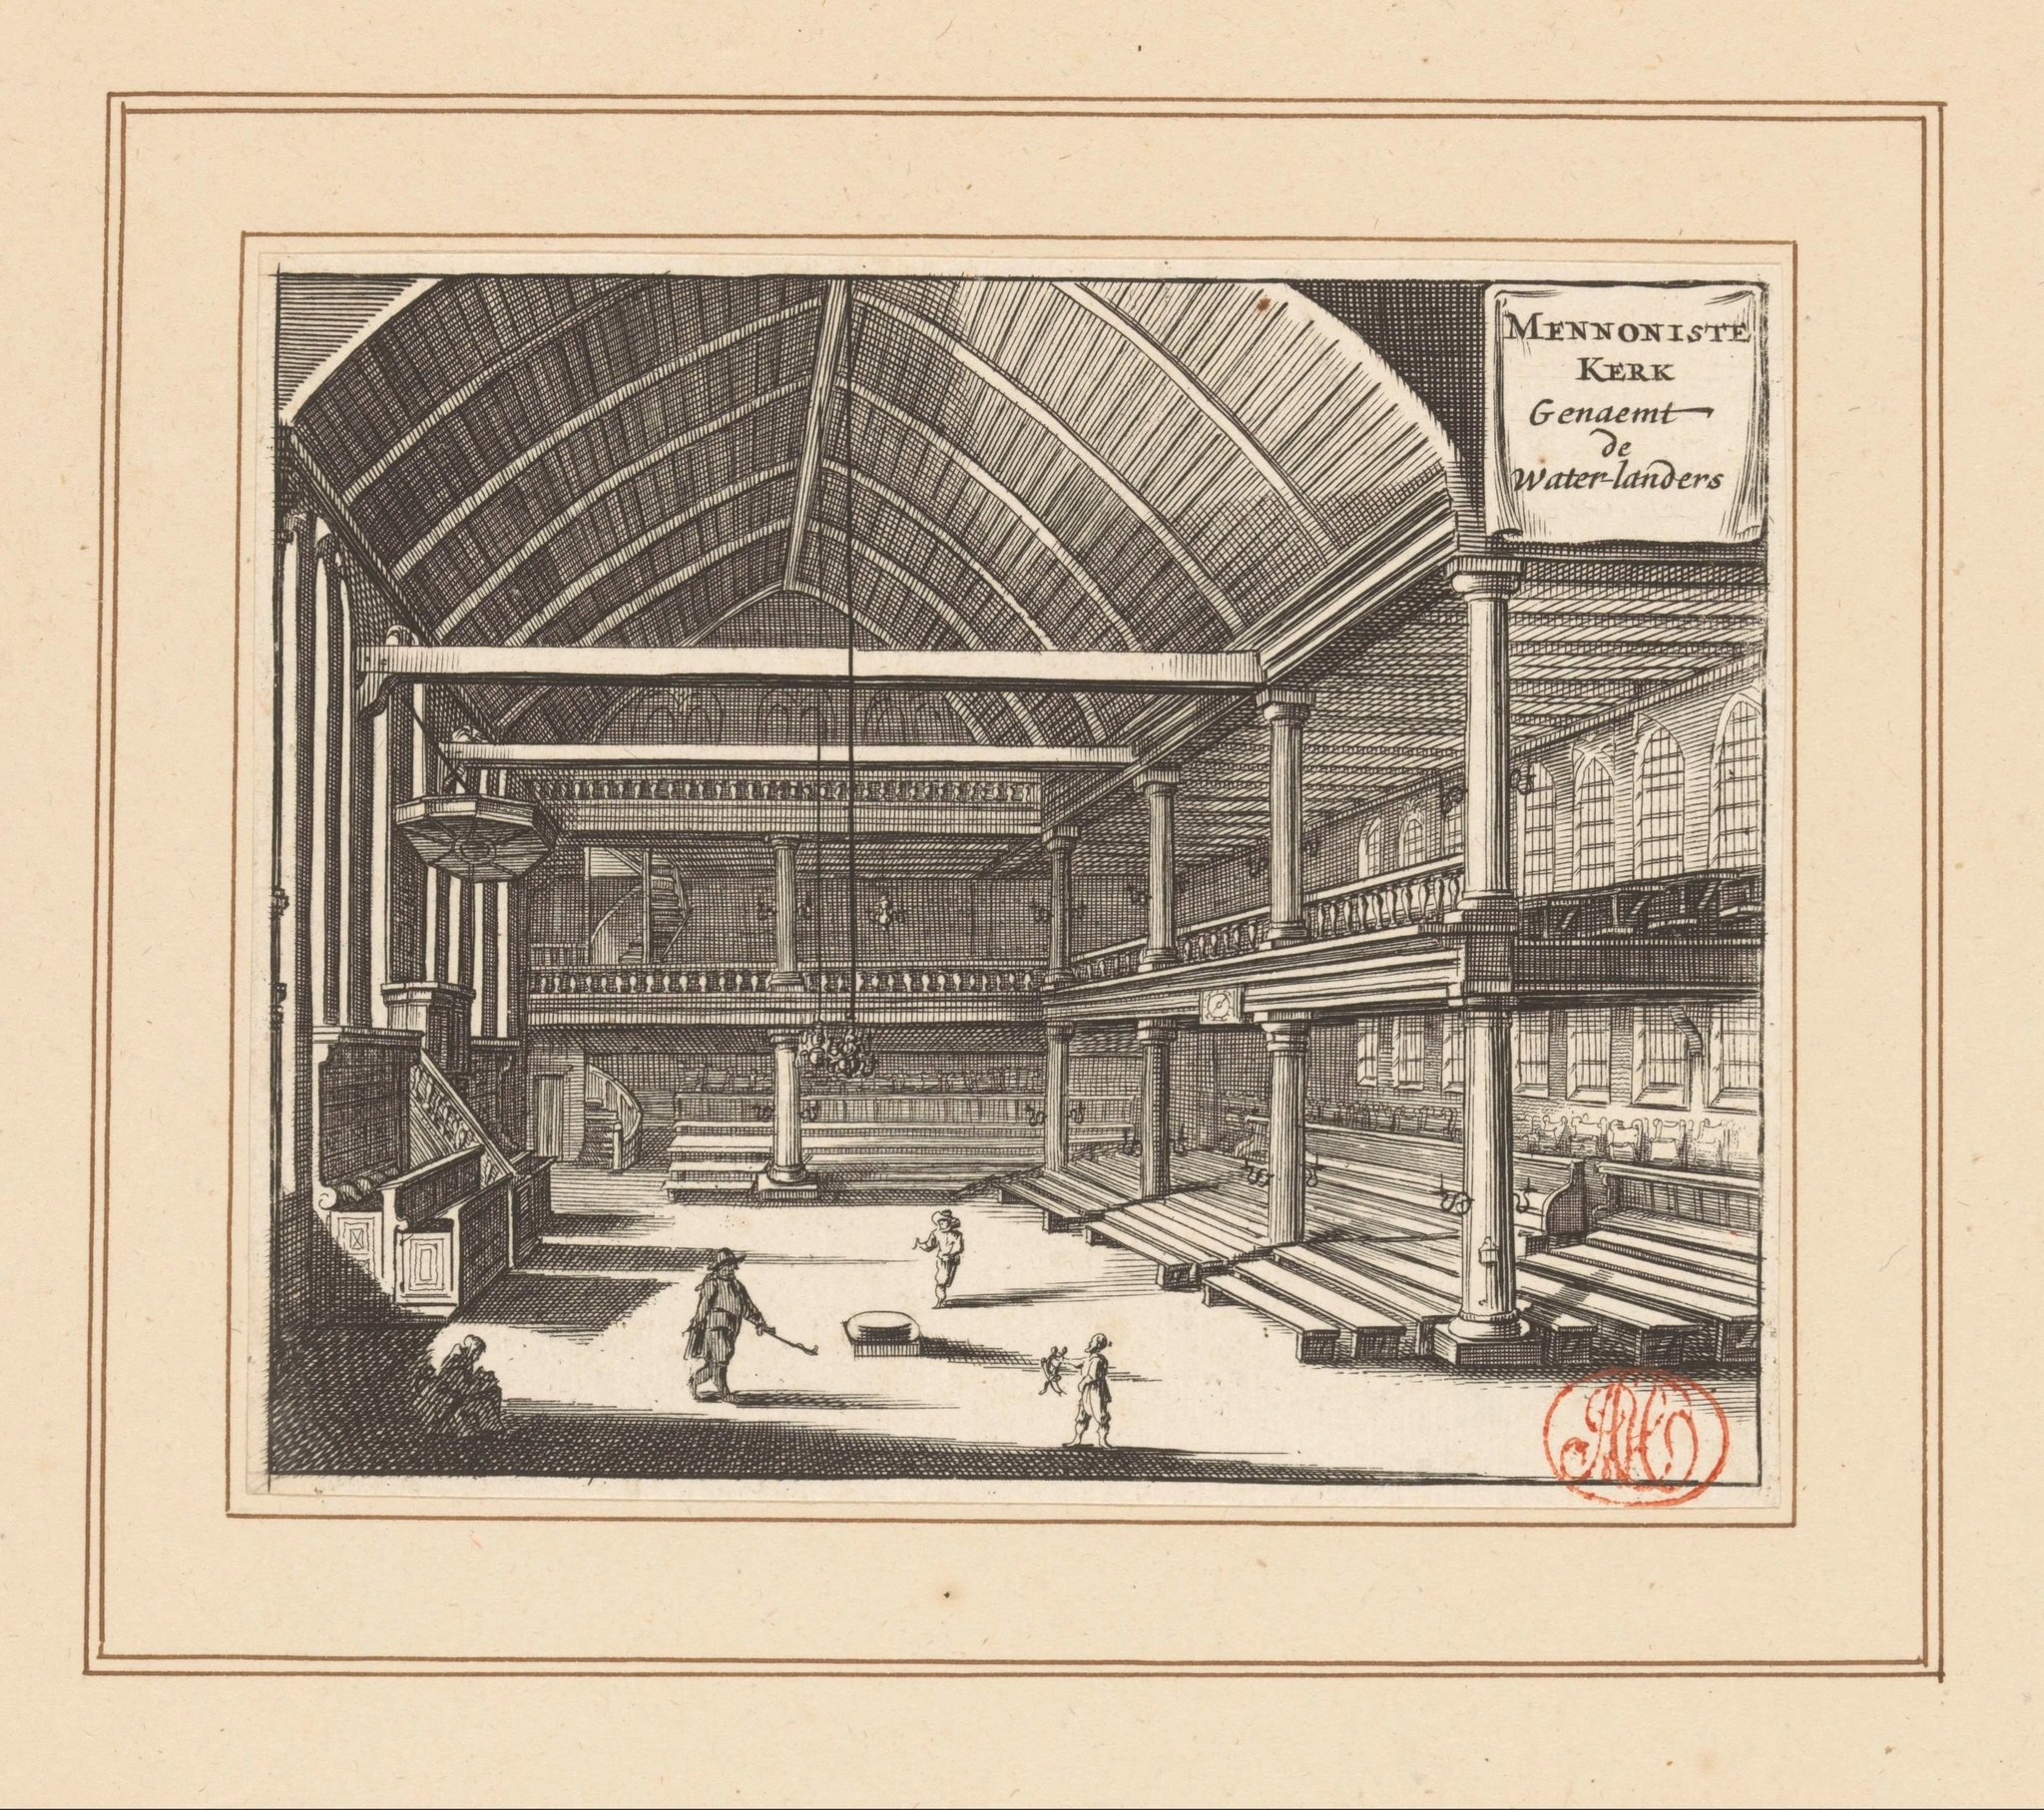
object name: book illustration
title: Interieur van de Doopsgezinde Kerk Bij de Toren te Amsterdam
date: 1664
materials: paper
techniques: engraving, etching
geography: amsterdam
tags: protestant churches and denominations (mennonites), interior of church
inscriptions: collector's mark: Lugt 195, collector's mark: Lugt 2233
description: Huidige staat van prent ook gebruikt in: Fockens, Melchior. Beschrijvingh Der wijdt-vermaarde Koop-stadt Amstelredam (…). 3de druk. Amsterdam: Marcus Willemsz. Doornick, 1664. En in: Zesen, Philipp von. Beschreibung der Stadt Amsterdam (…). Amsterdam: Marcus Wilhelm Doornick, 1664. Tweede bekende staat (met toevoeging Franse titel) ook gebruikt in: Domselaer, Tobias en Isaac Commelin. Beschryvinge van Amsterdam (…). 6 dln. Amsterdam: Marcus Willemsz. Doornick, 1665, dl. 4, p. 99. Derde bekende staat (rechtsboven genummerd: 22) ook gebruikt in een onbekende publicatie. Vierde bekende staat (rechtsboven genummerd: 23) ook gebruikt in: Alle de Voornaamste Gebouwen der wijdvermaarde koopstad Amsterdam (...). Amsterdam: Hieronymus Sweerts, Jan Bouman en Aart Dircksz. Oossaan, [ca. 1680-1682]. Vijfde bekende staat (met opgewerkte schaduw) ook gebruikt in verschillende latere zeventiende- en achttiende-eeuwse publicaties.